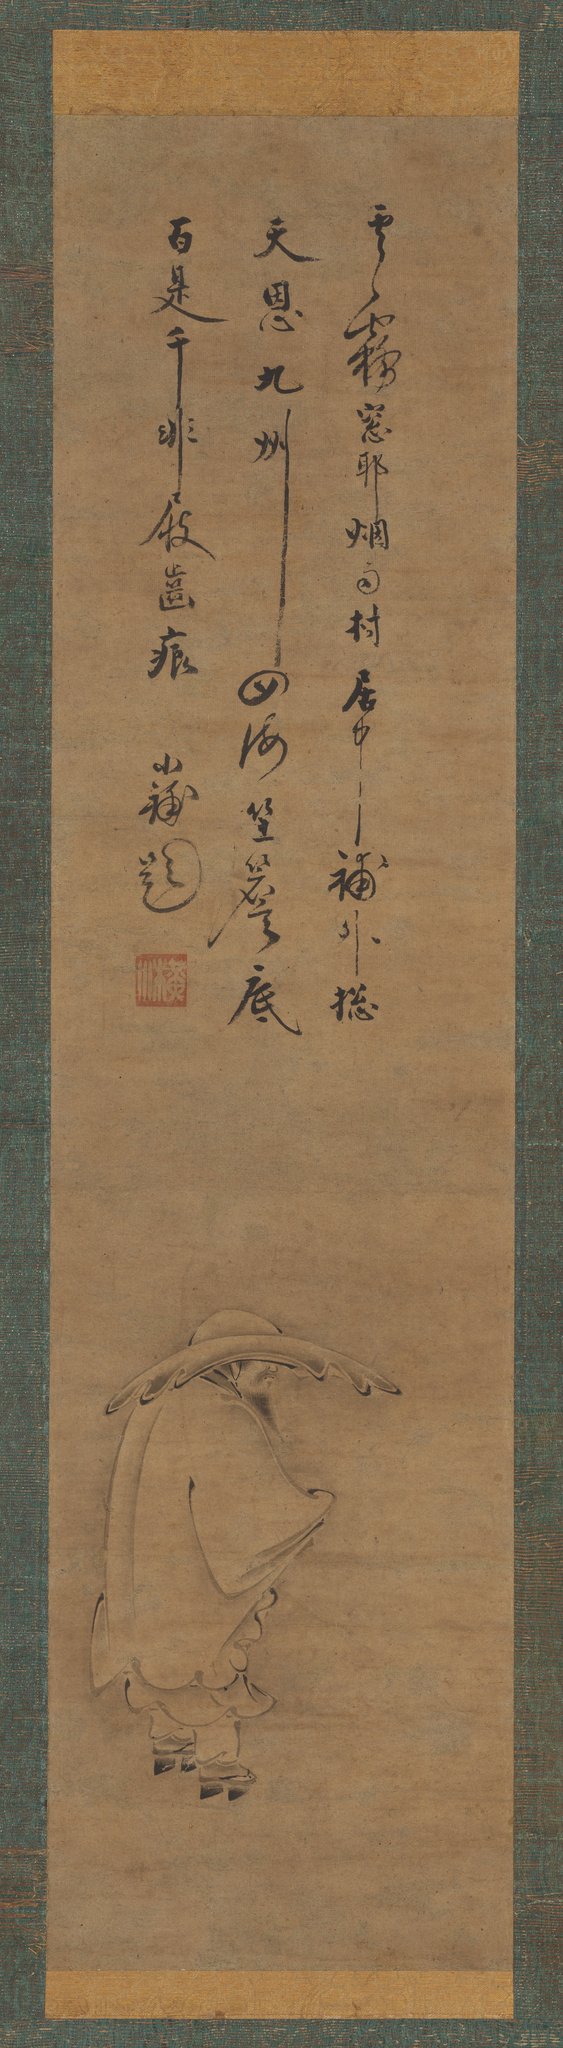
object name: hanging scroll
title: Su Dongpo in a Borrowed Hat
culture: japanese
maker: ōsen keisan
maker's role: artist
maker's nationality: japanese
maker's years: 1429-1493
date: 1467-1500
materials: ink, paper